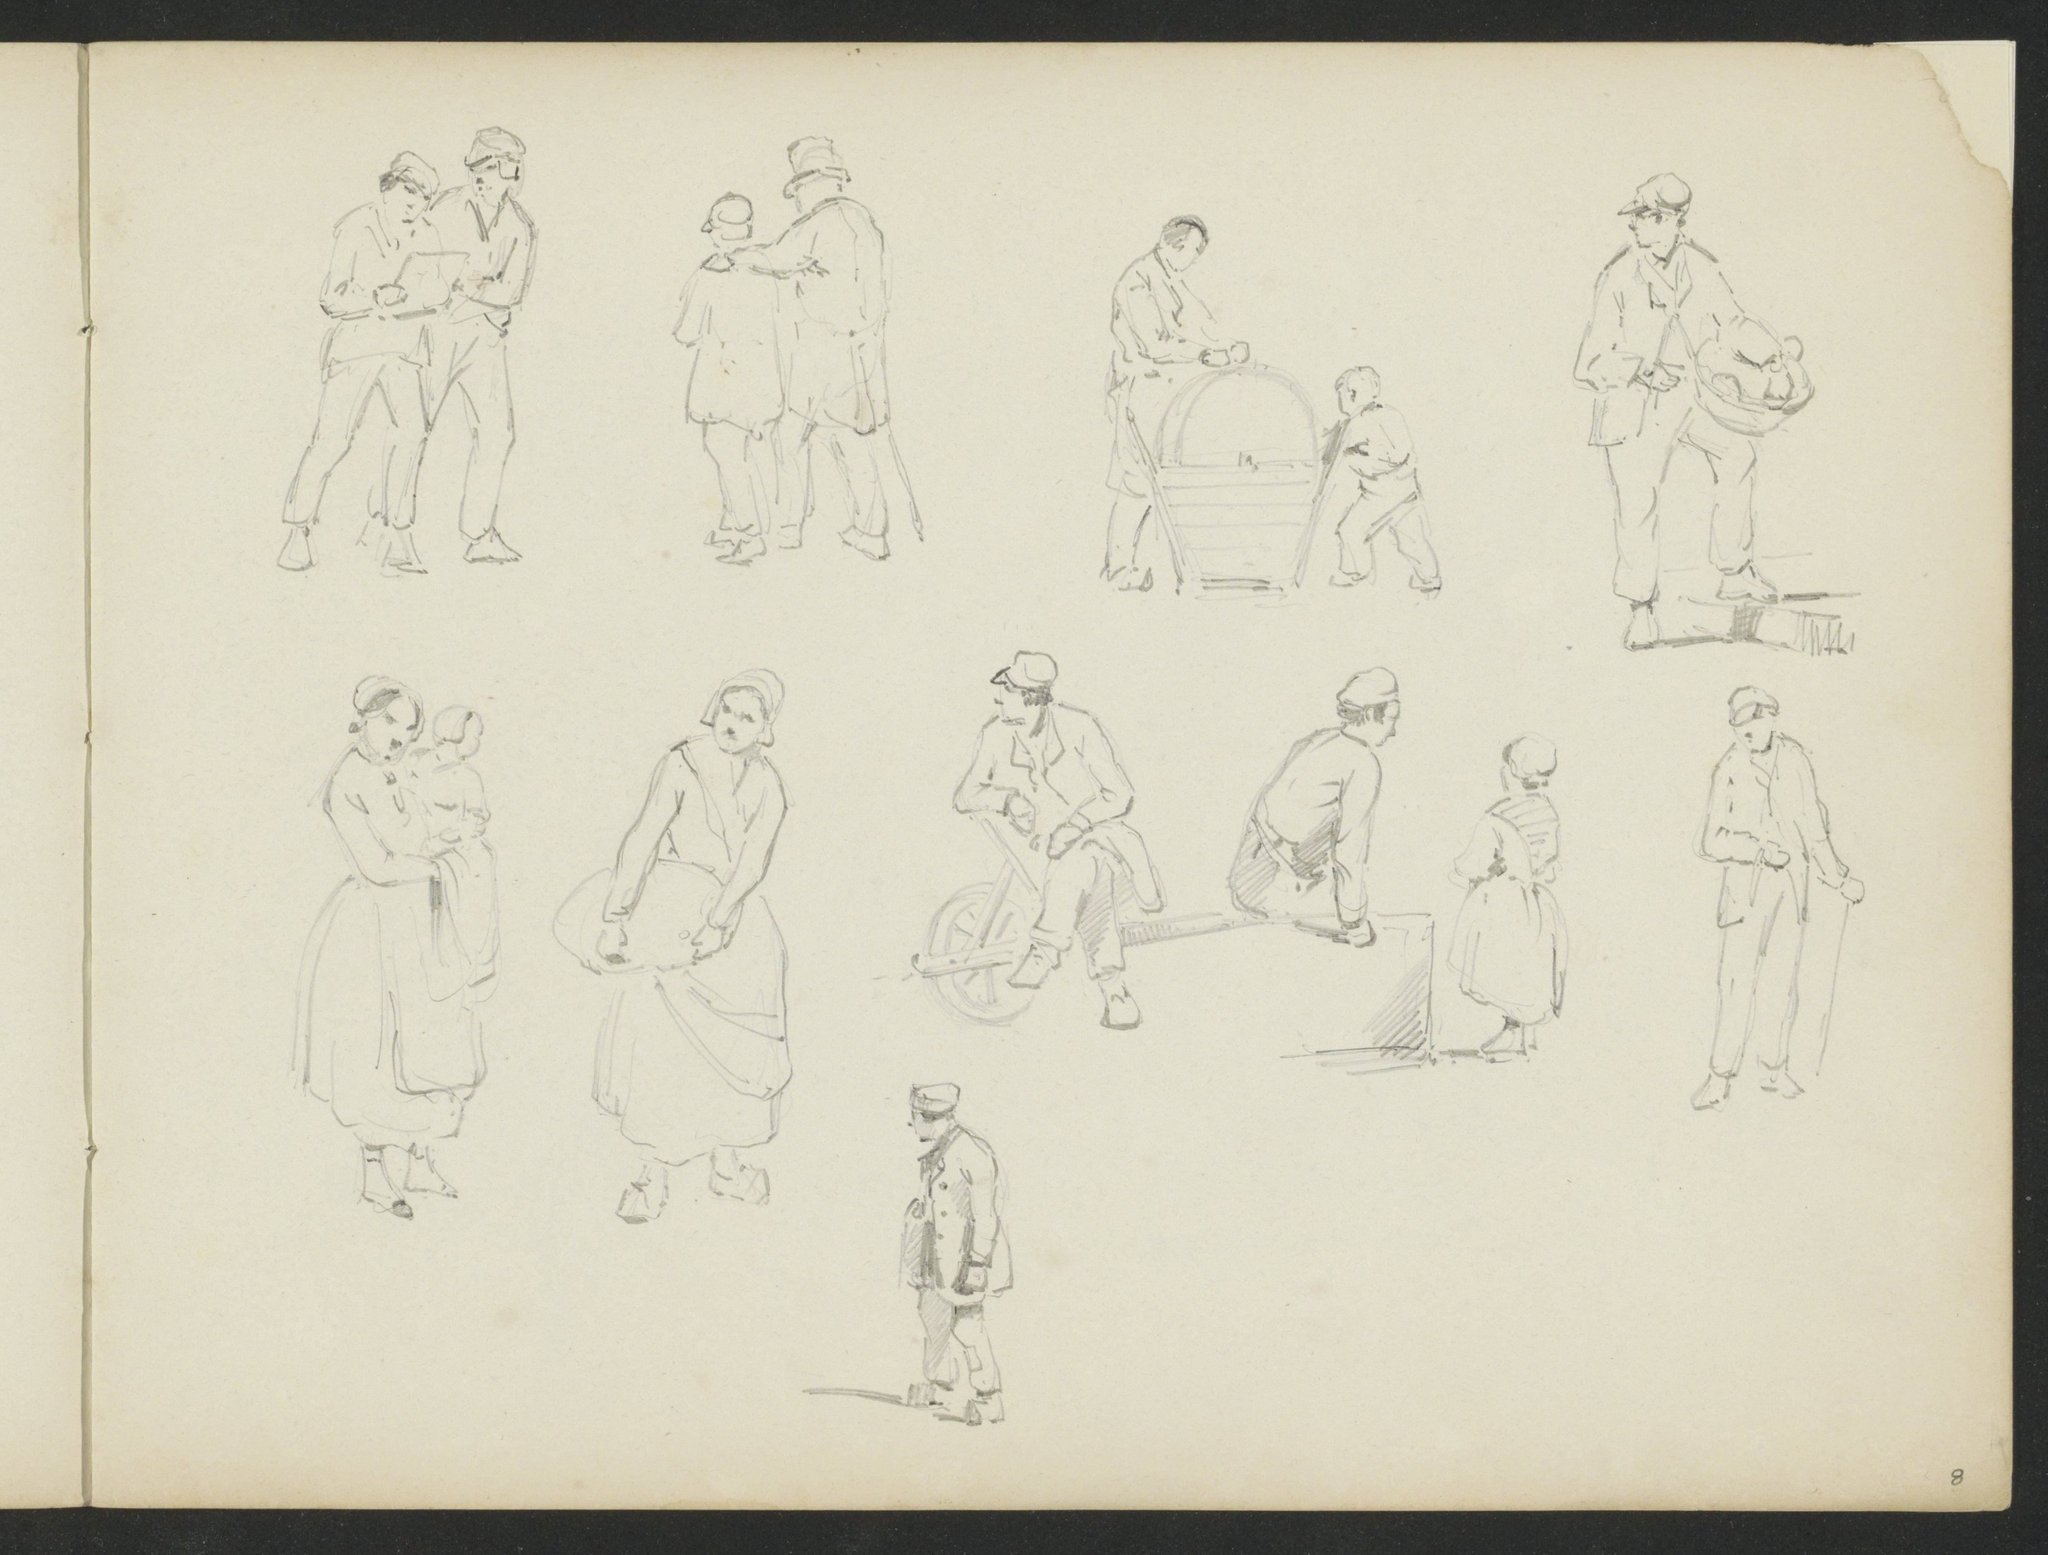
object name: sketchbook leaf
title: Figuren in verschillende houdingen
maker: adrianus eversen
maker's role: draughtsman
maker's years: 1818-1897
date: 1828-1897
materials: paper, pencil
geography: netherlands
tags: adult woman, carrying something, adult man, child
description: Mannen, vrouwen en kinderen in verschillende houdingen. Sommigen dragen spullen. In het midden een man op een handkar. Blad 8 uit een schetsboek met 11 bladen.